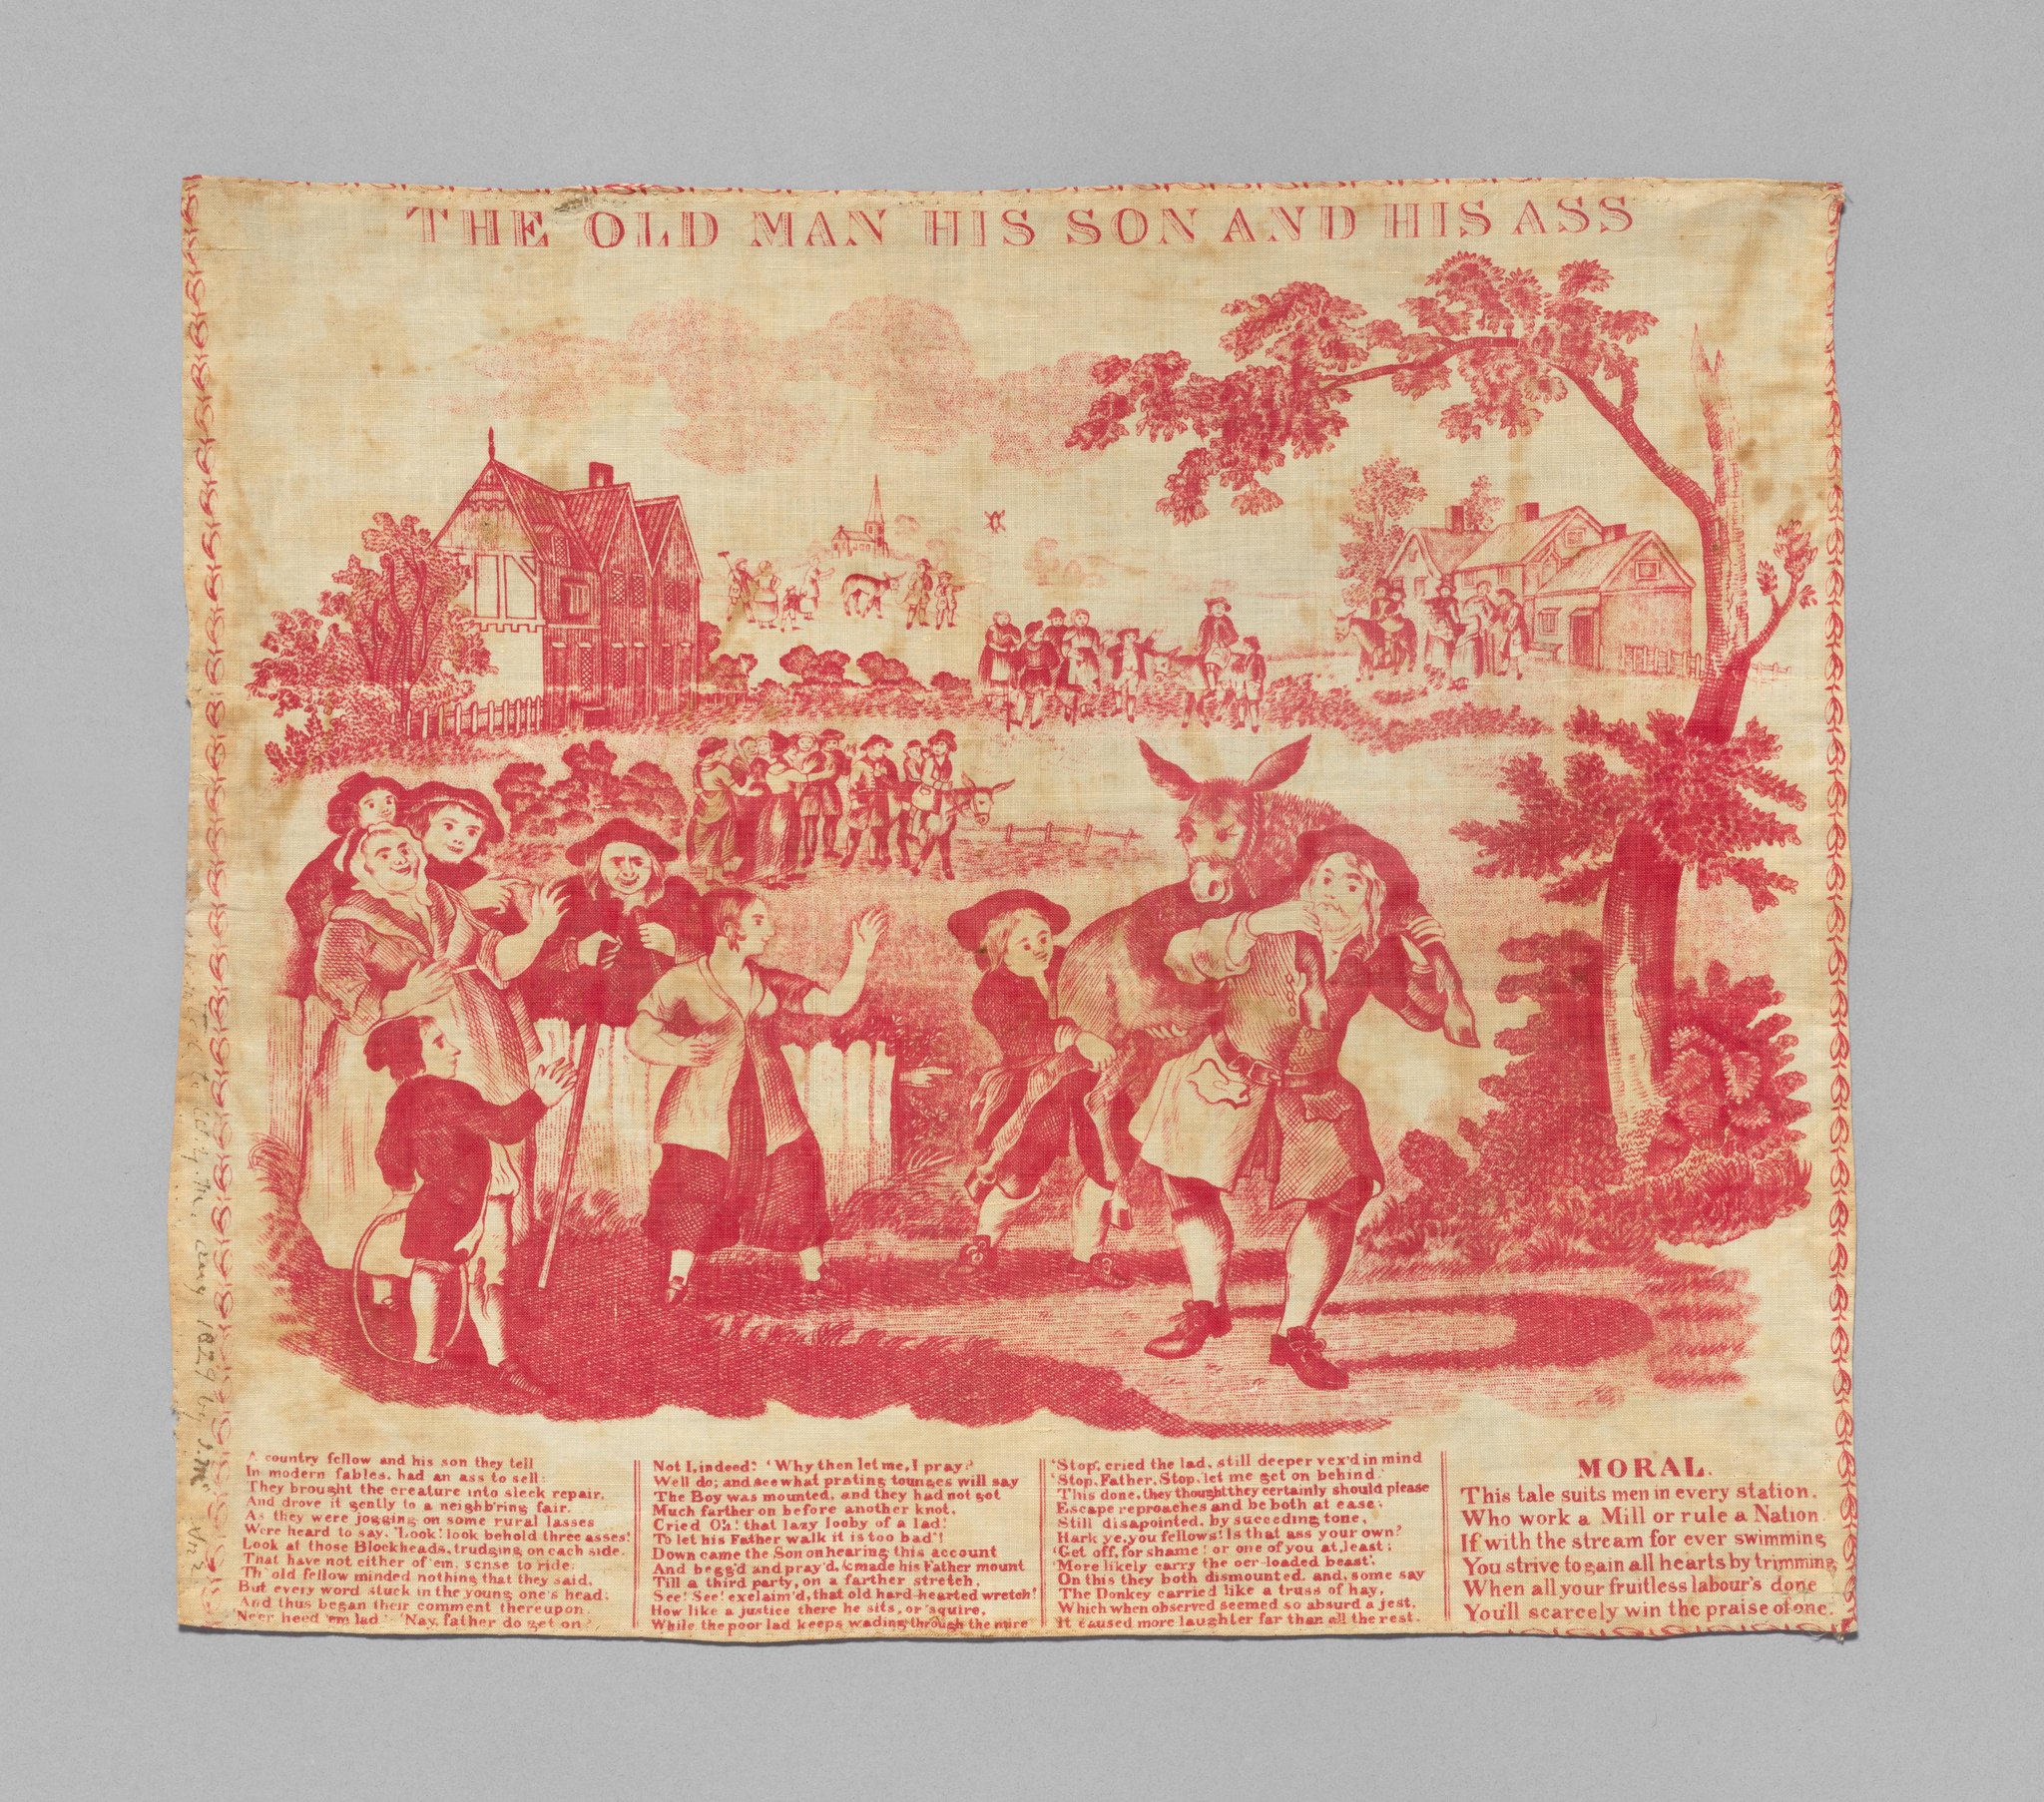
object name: handkerchief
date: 1767-1833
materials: cotton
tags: donkeys